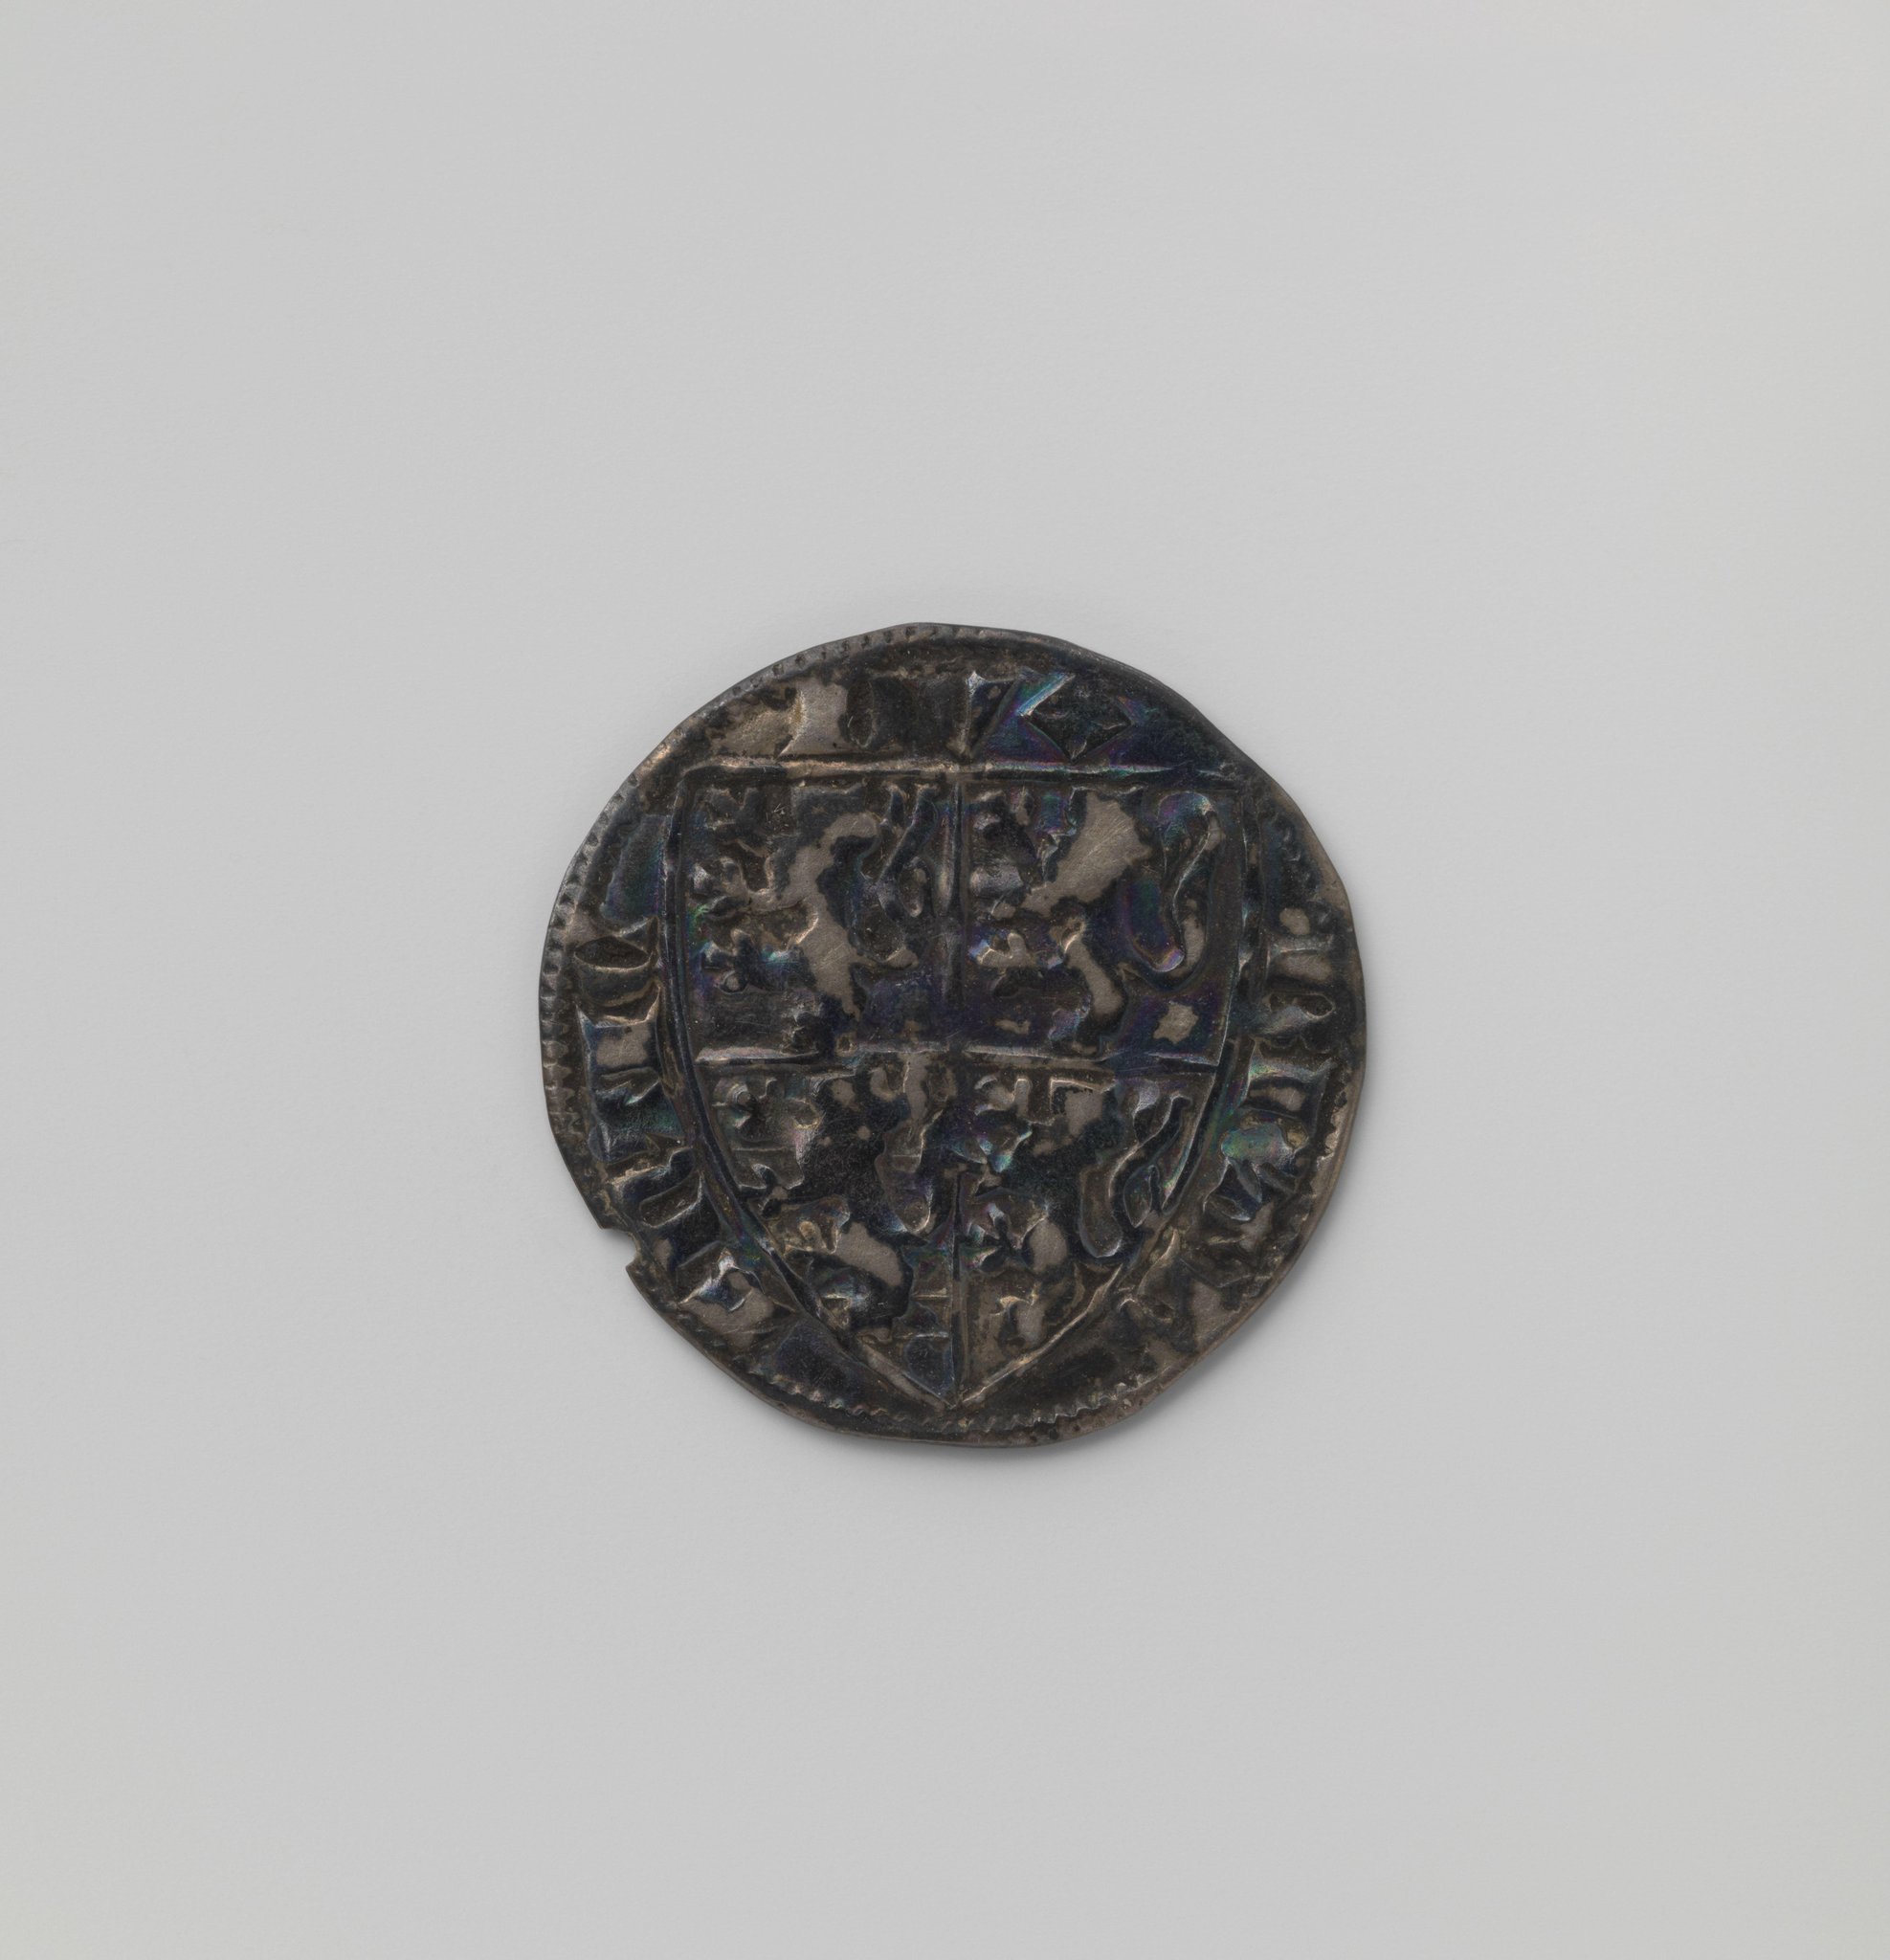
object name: coin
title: Luxemburg, Wenceslaus II, sterling brabantinus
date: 1355-1383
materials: silver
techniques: striking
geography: luxembourg city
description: Voorzijde: in een punt uitlopend gecombineerd Limburgs/Boheems/Luxemburgs wapenschild, waaromheen omschrift: DVX-BRAB-ANTIE. Keerzijde: kort gebloemd kruis. Daaromheen omschrift: MONETA LOCEBGES.